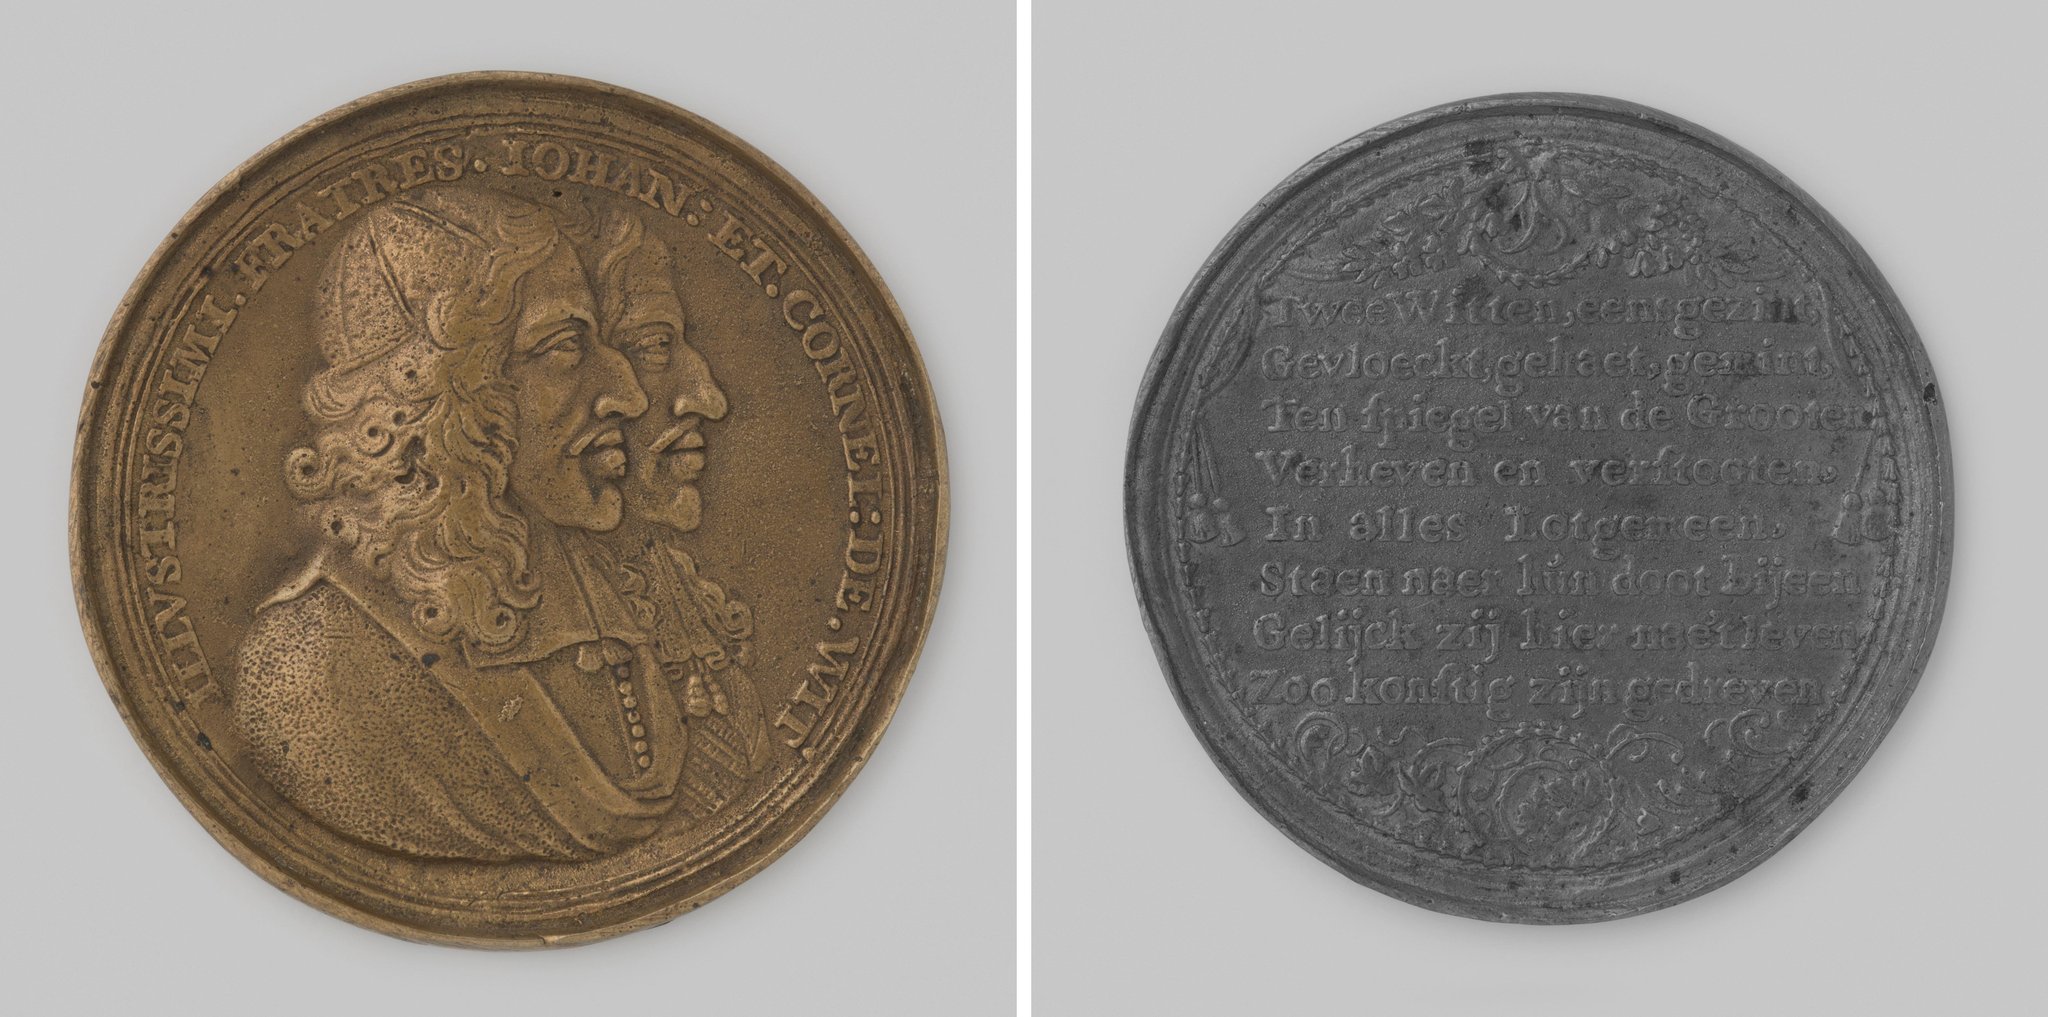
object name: history medal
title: Moord op de gebroeders Johan en Cornelis de Wit in 's Gravenhage 1672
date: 1672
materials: brass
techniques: casting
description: Messing gegoten penning, op de voorzijde de geconjugeerde borstbeelden van Johan en Cornelis de Witt, met omschrift, op de keerzijde acht regels tekst binnen een krans versierd met bladranken.